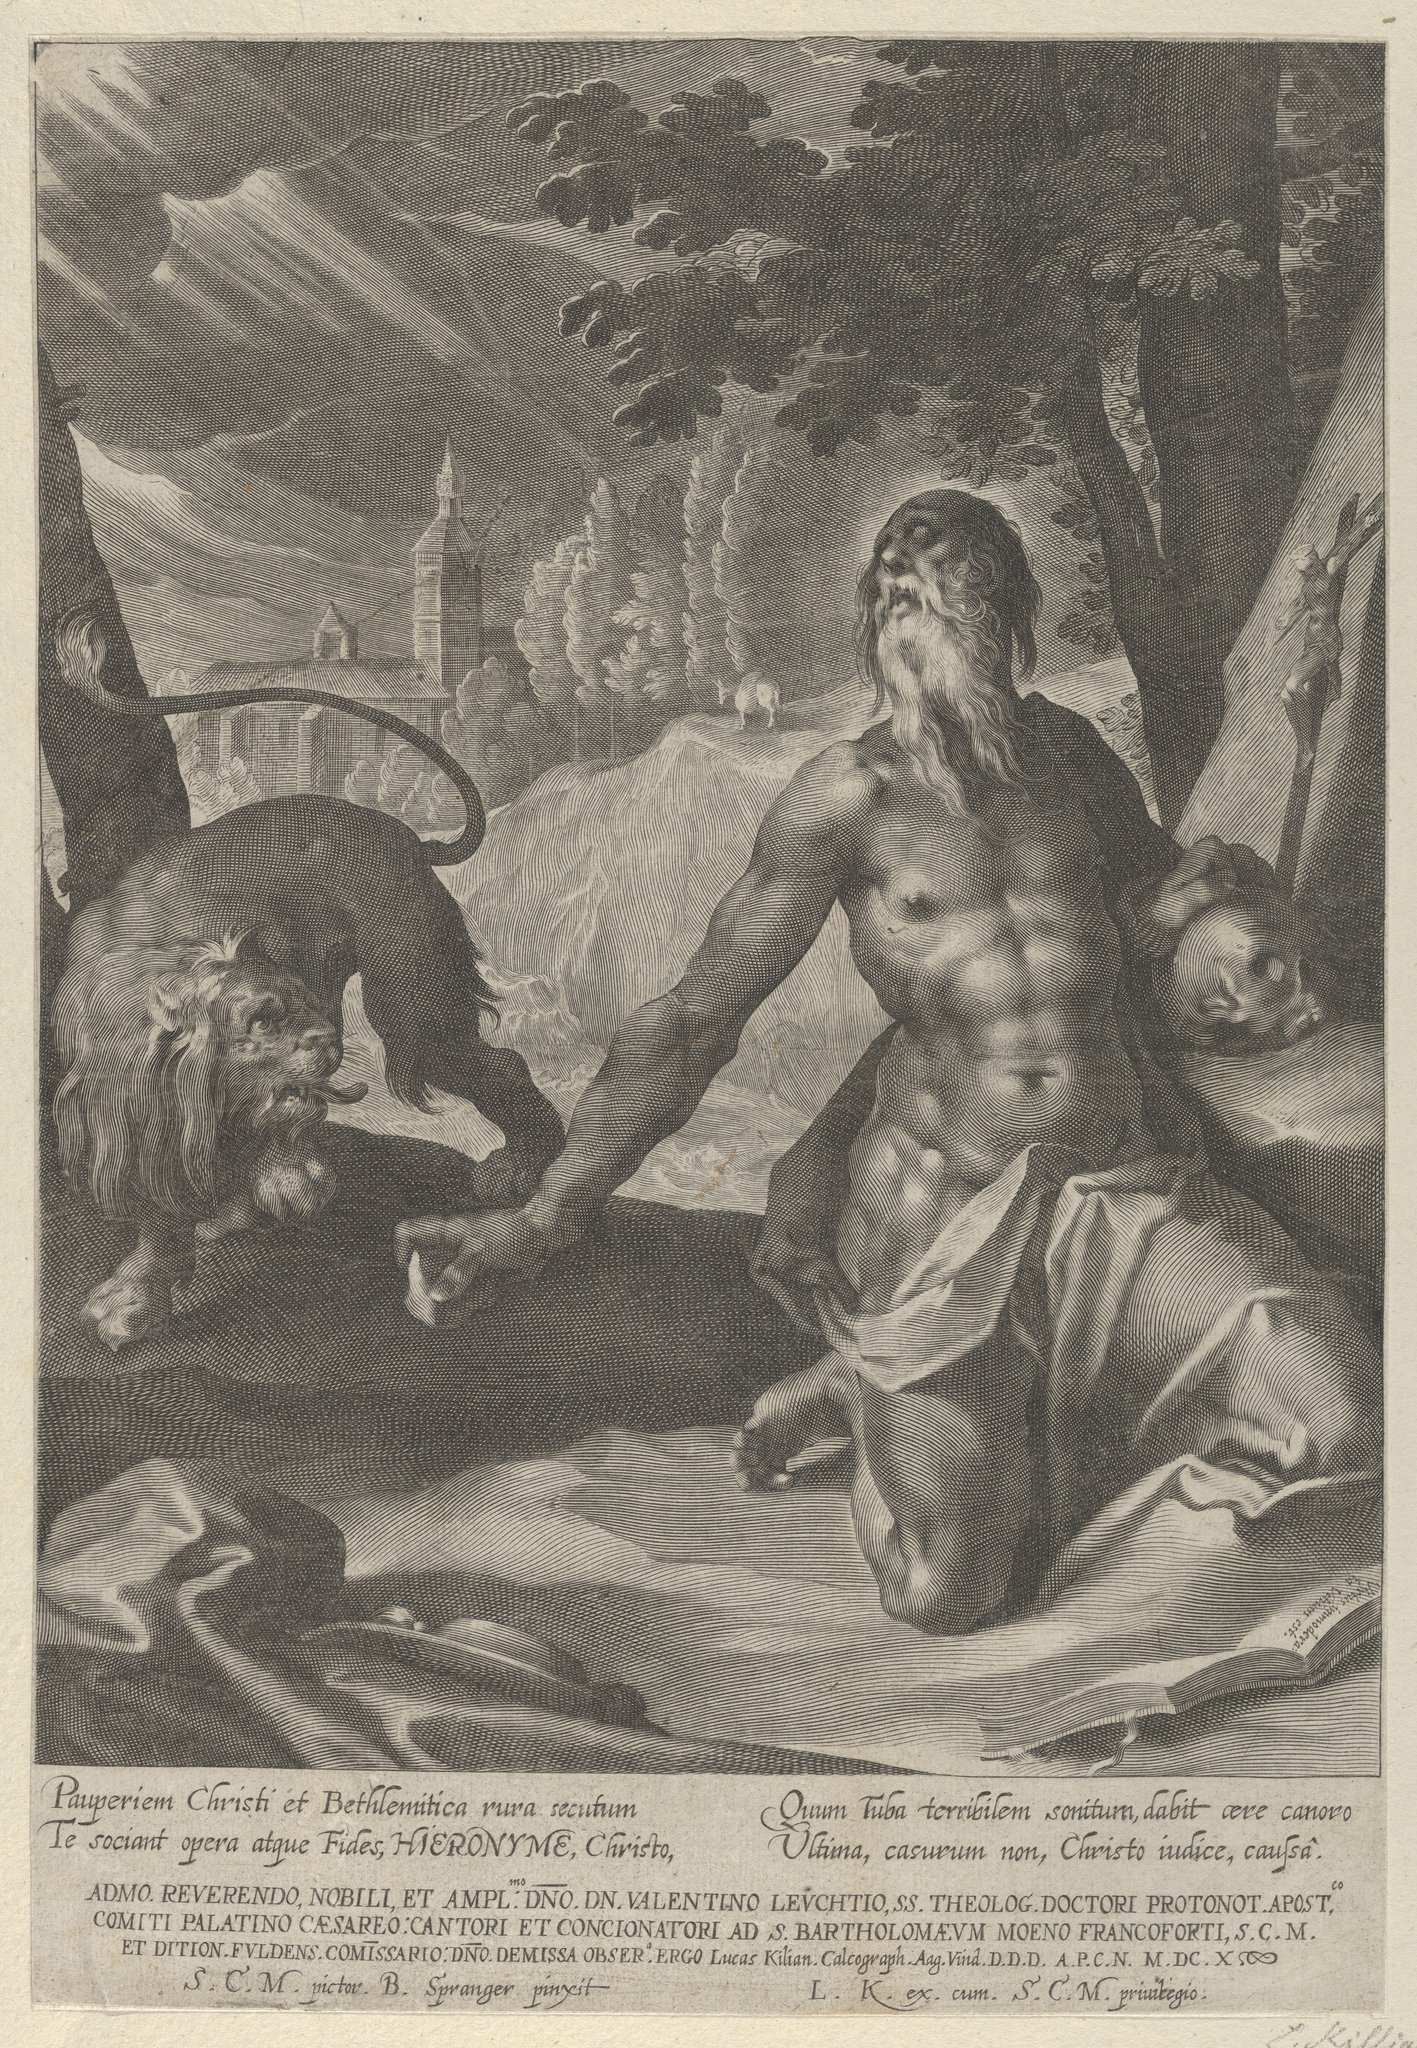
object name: print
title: Saint Jerome in the Desert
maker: lucas kilian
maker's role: artist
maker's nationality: german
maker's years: 1579-1637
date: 1610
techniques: engraving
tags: skulls,lions,deserts,saint jerome